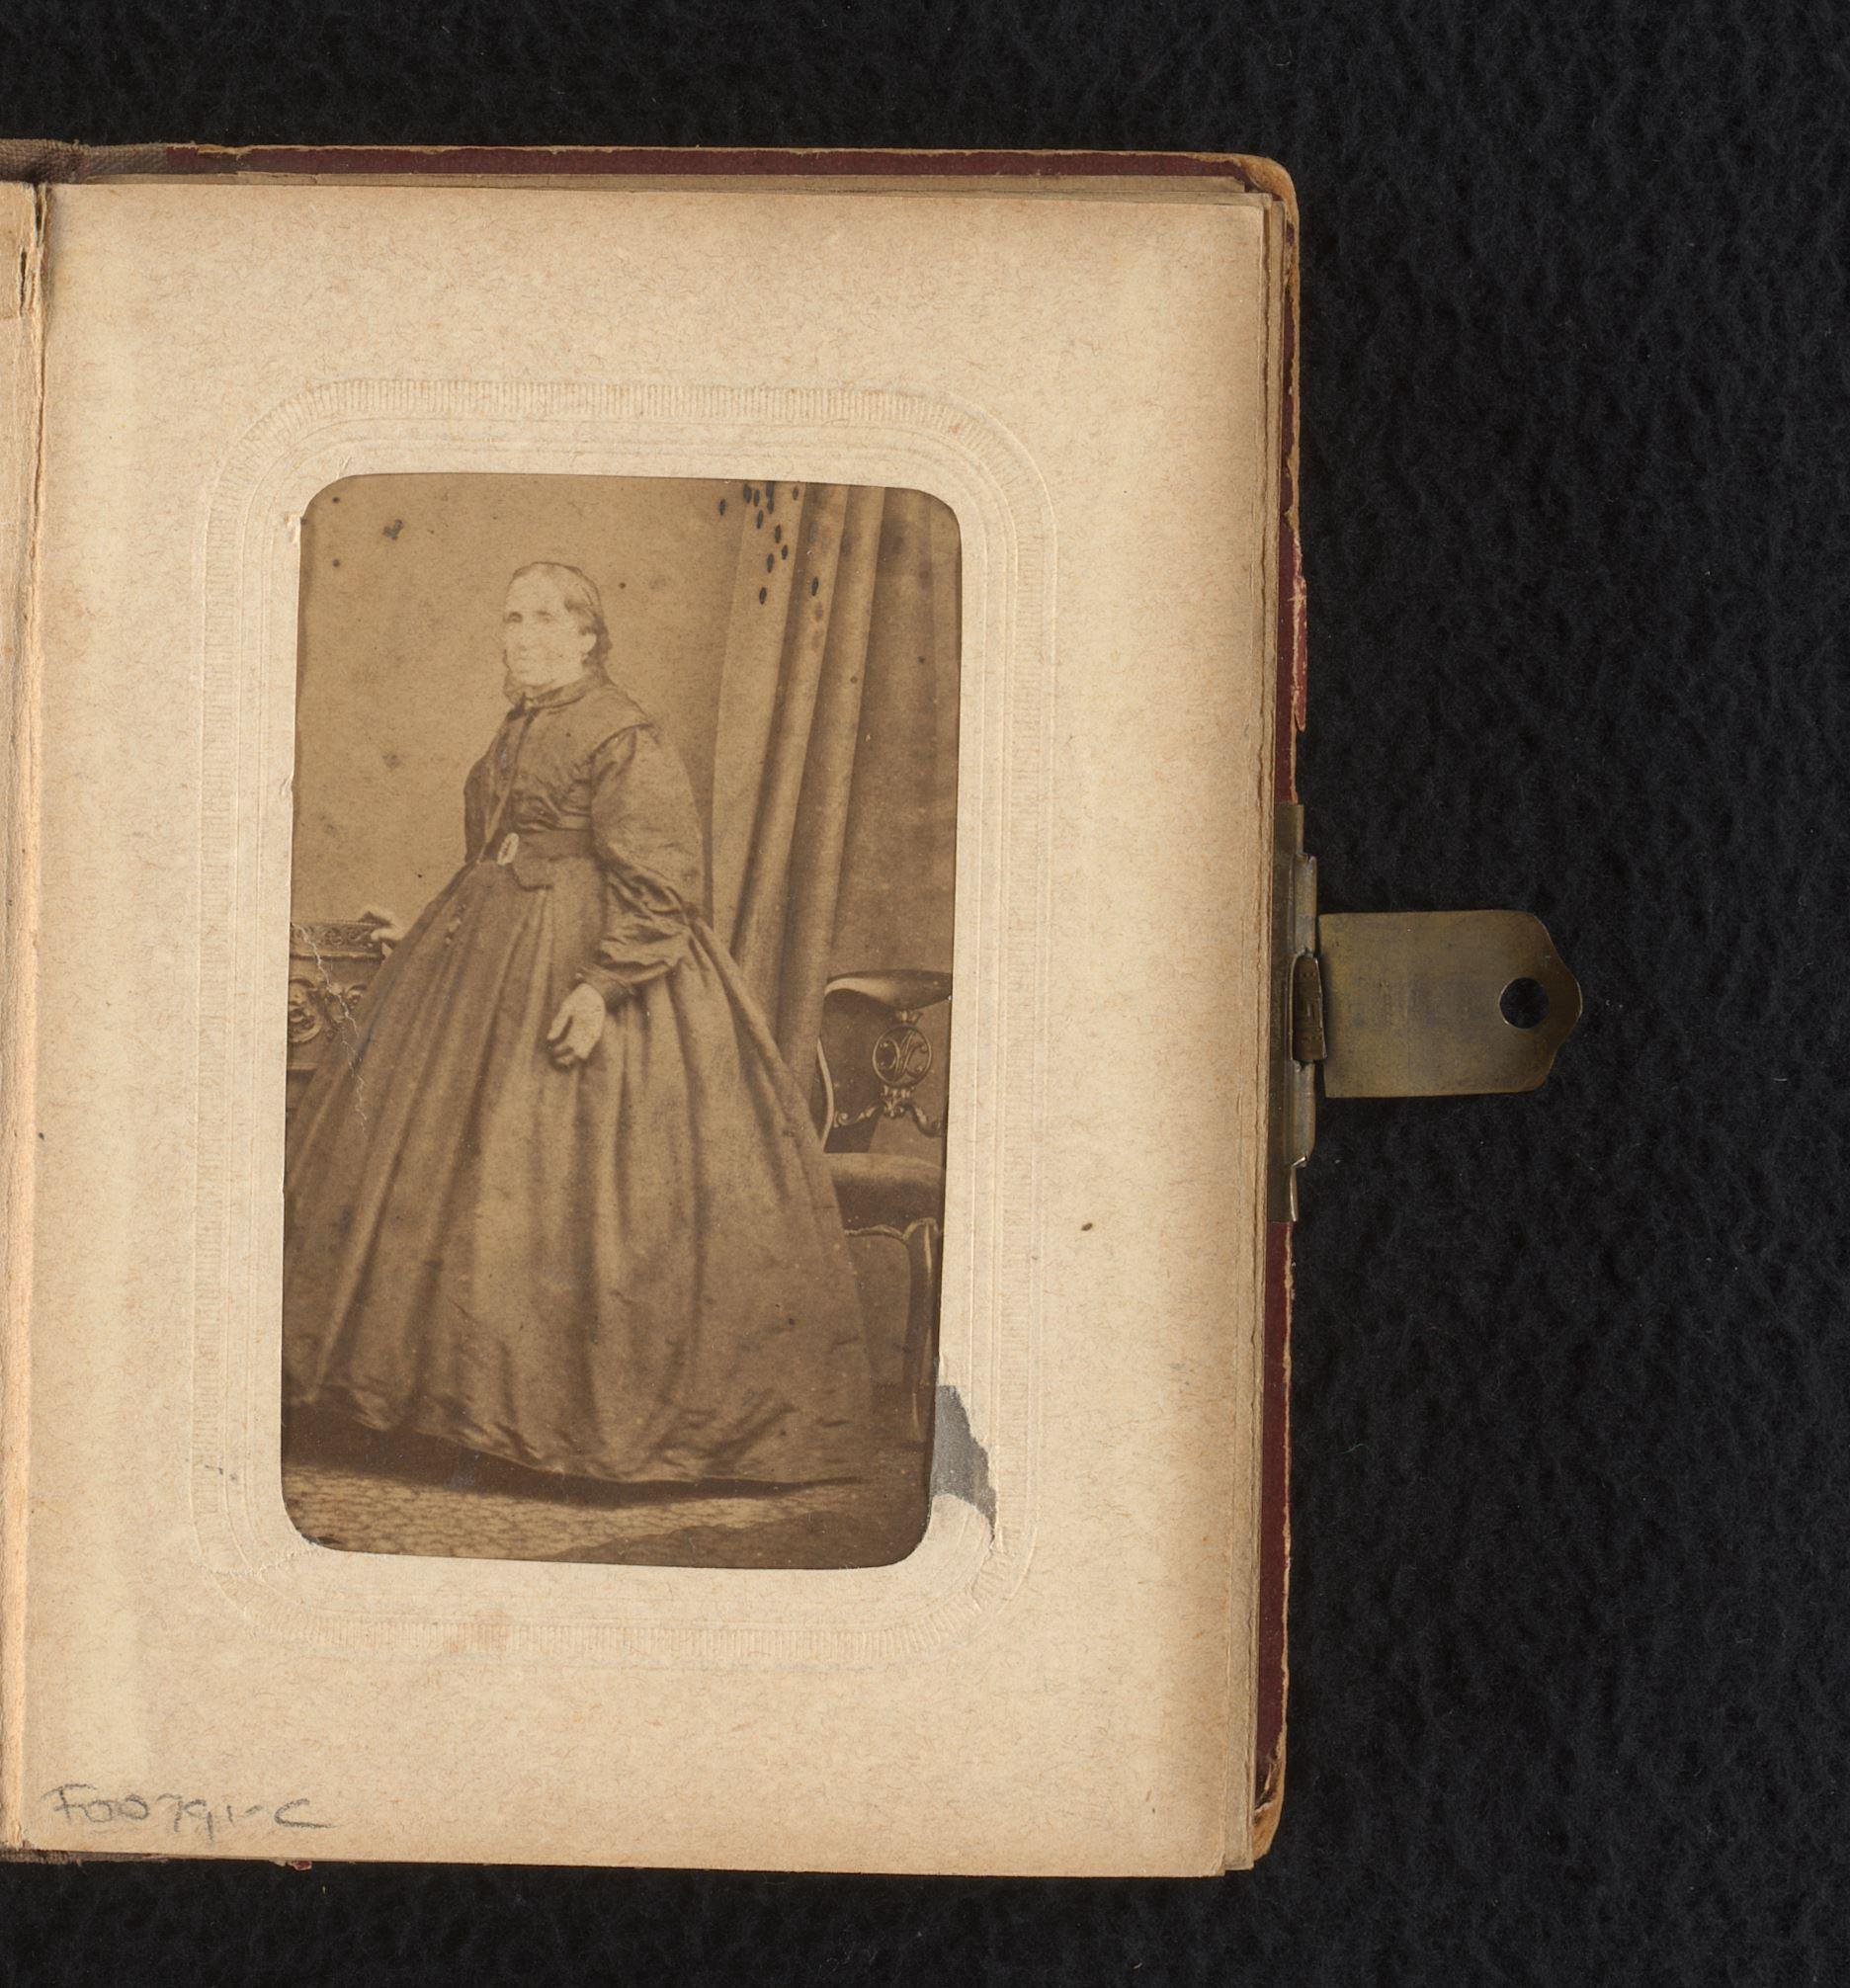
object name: album leaf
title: Portret van een staande vrouw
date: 1855-1880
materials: cardboard, photographic support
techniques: photography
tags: historical persons, standing figure - aa - female human figure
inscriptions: inscription: ‘City of London/ Institute of Photography/ 44. Ludgate Hill E.C./ Ajoining the Railway (...)’